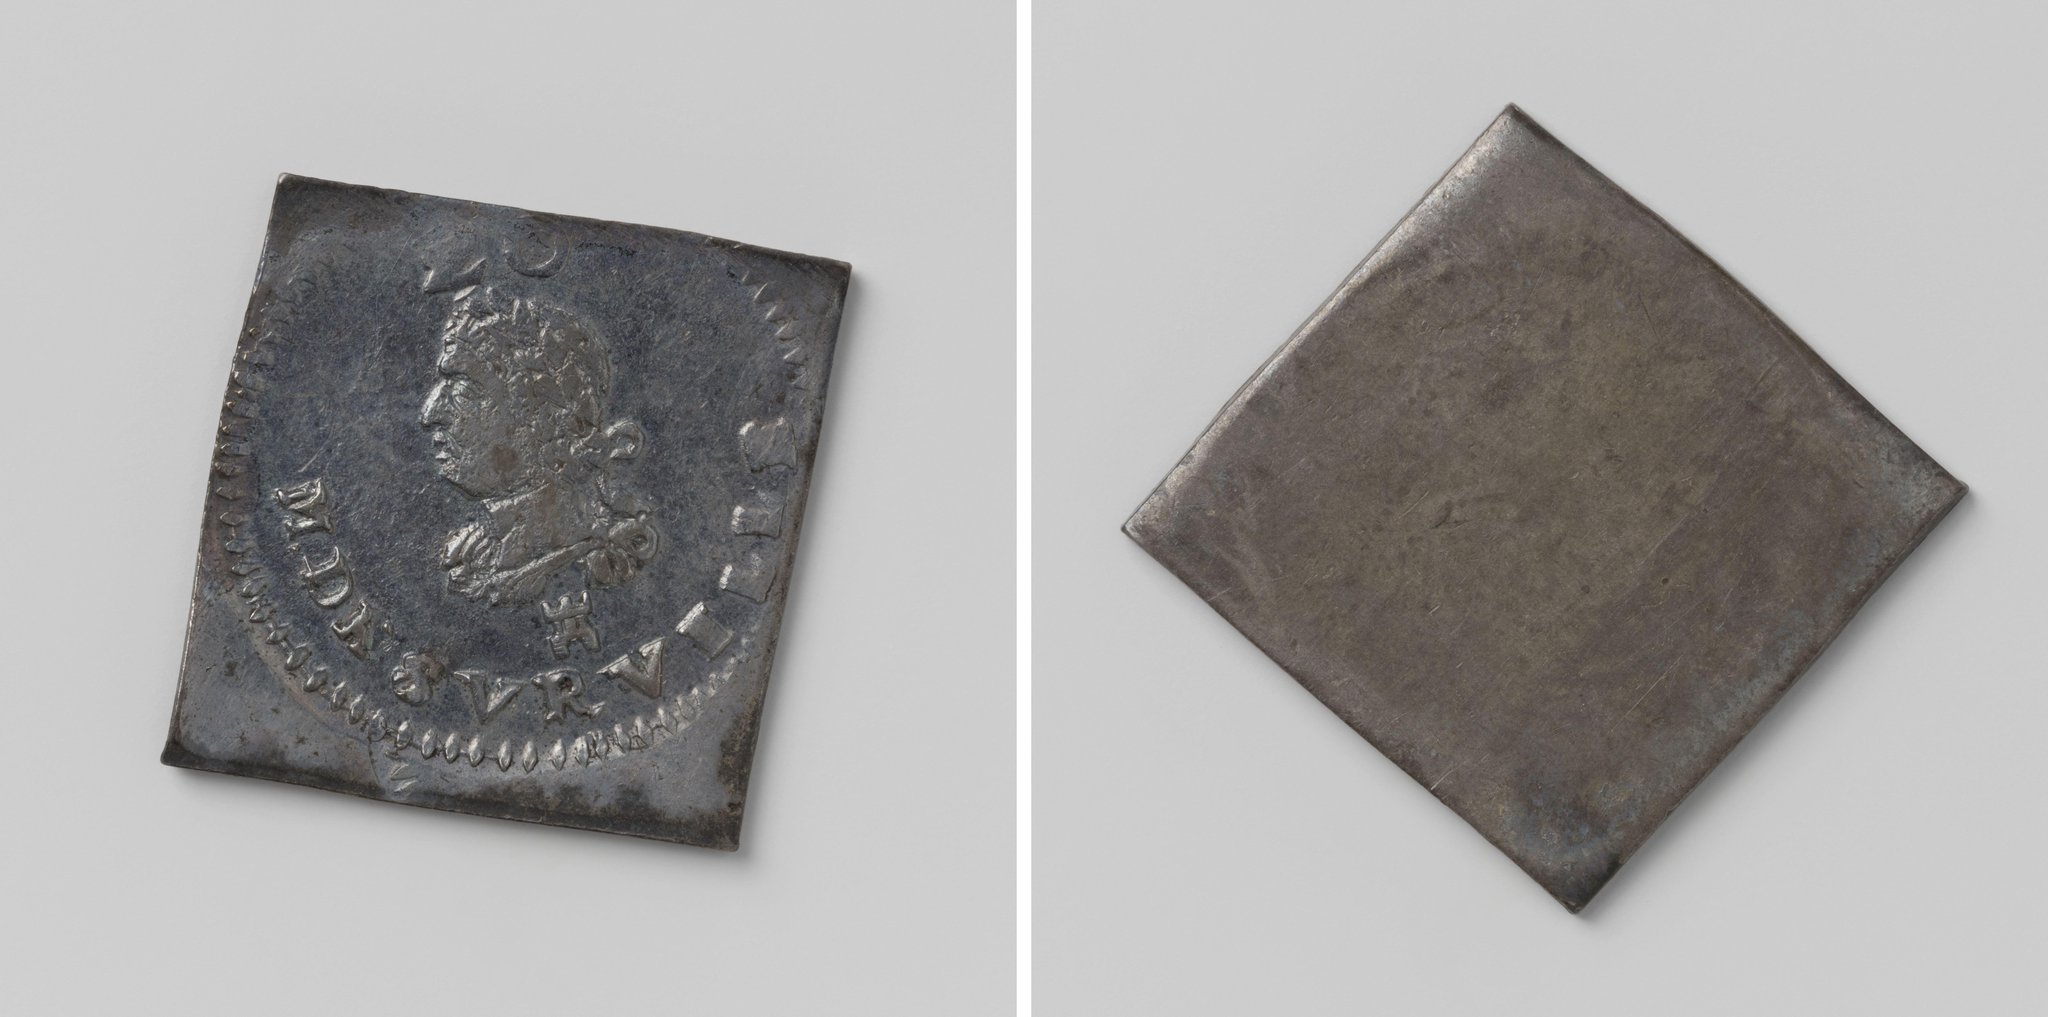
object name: siege coin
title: Twintig stuiver, noodmunt uit Doornik door de bondgenoten ingenomen, geslagen op last van maarschalk de Surville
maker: Anonymous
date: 1709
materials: silver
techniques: striking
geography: doornik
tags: maarschalk de surville, doornik, inname van doornik (1709)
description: eenzijdige, min of meer vierkante noodmunt. Voorzijde: borststuk man met lauwerkrans onder cijfer 20, boven torentje binnen omschrift en parelrand. Keerzijde: blanco